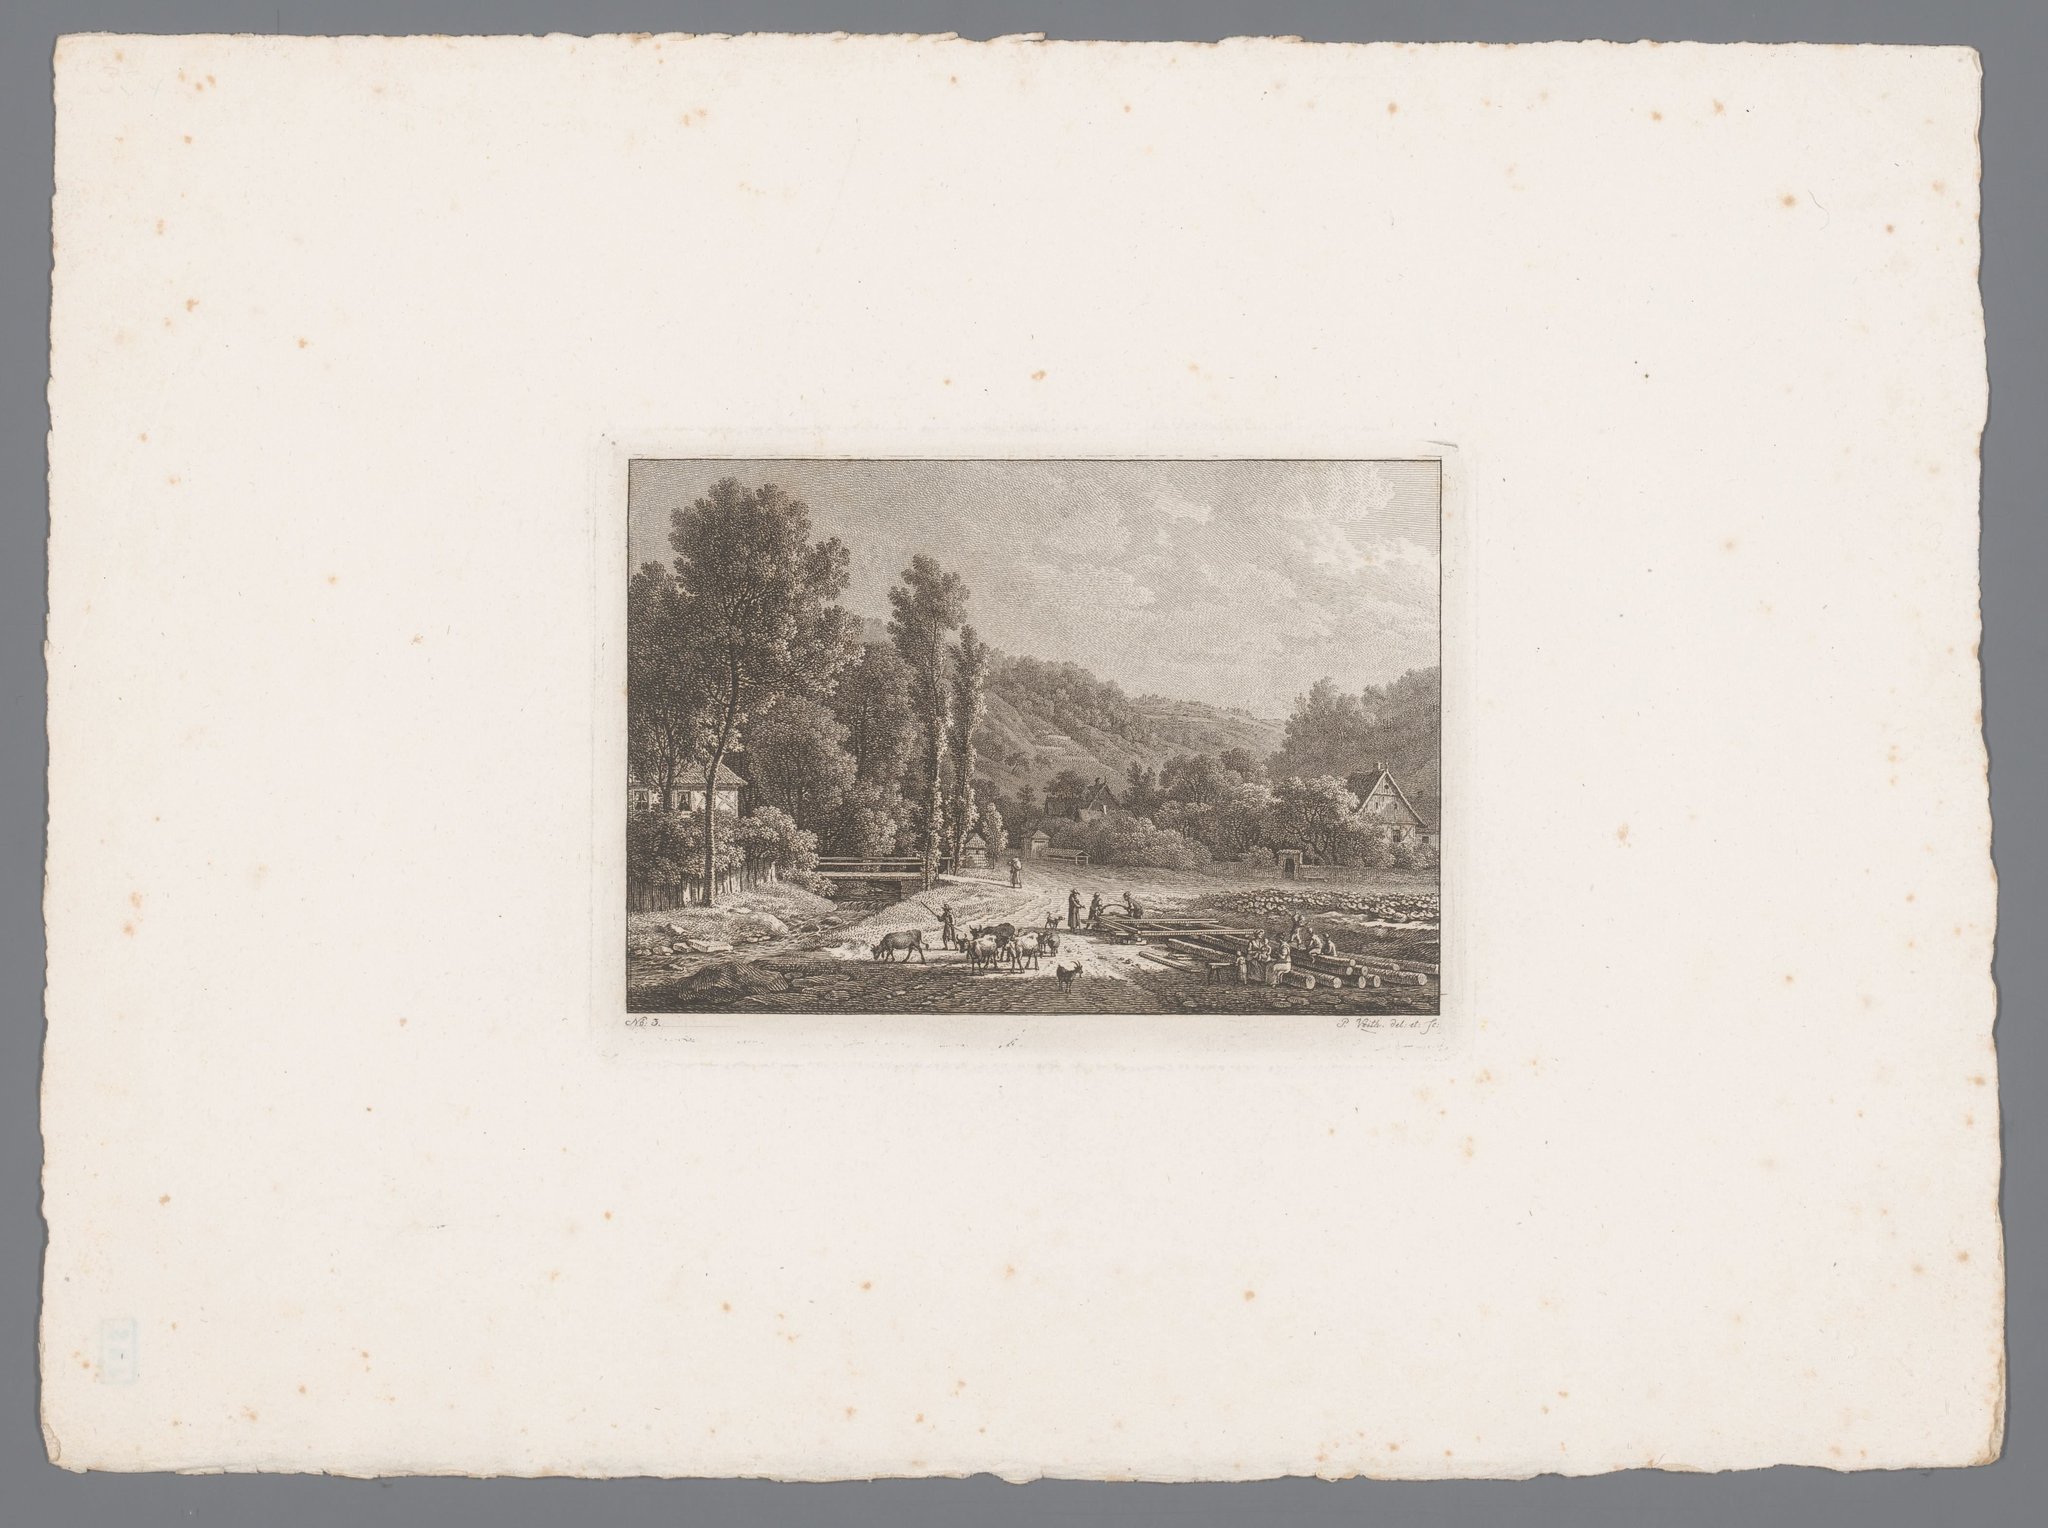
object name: print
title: Landschap met houtzagers en een herder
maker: philipp veith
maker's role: draughtsman, print maker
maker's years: 1768-1837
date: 1822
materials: paper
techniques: etching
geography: dresden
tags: landscapes, herding, herdsman, herdswoman, shepherd, shepherdess, cowherd, etc., sawyer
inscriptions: collector's mark: Lugt 2760, collector's mark: Lugt 3976, collector's mark: Lugt 2228